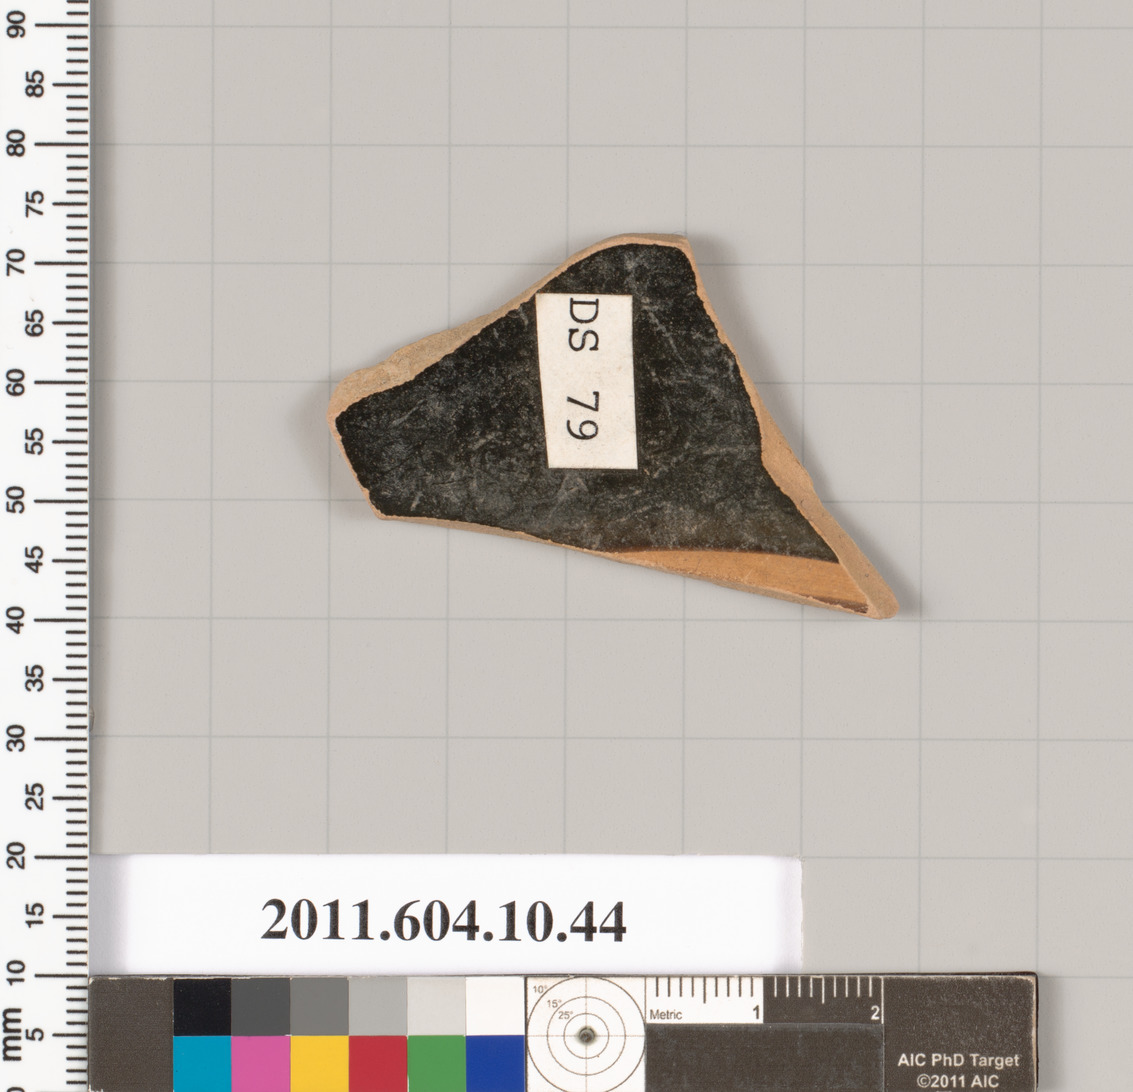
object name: kylix fragment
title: Terracotta fragment of a kylix (drinking cup)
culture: etruscan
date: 334-301 BCE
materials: terracotta